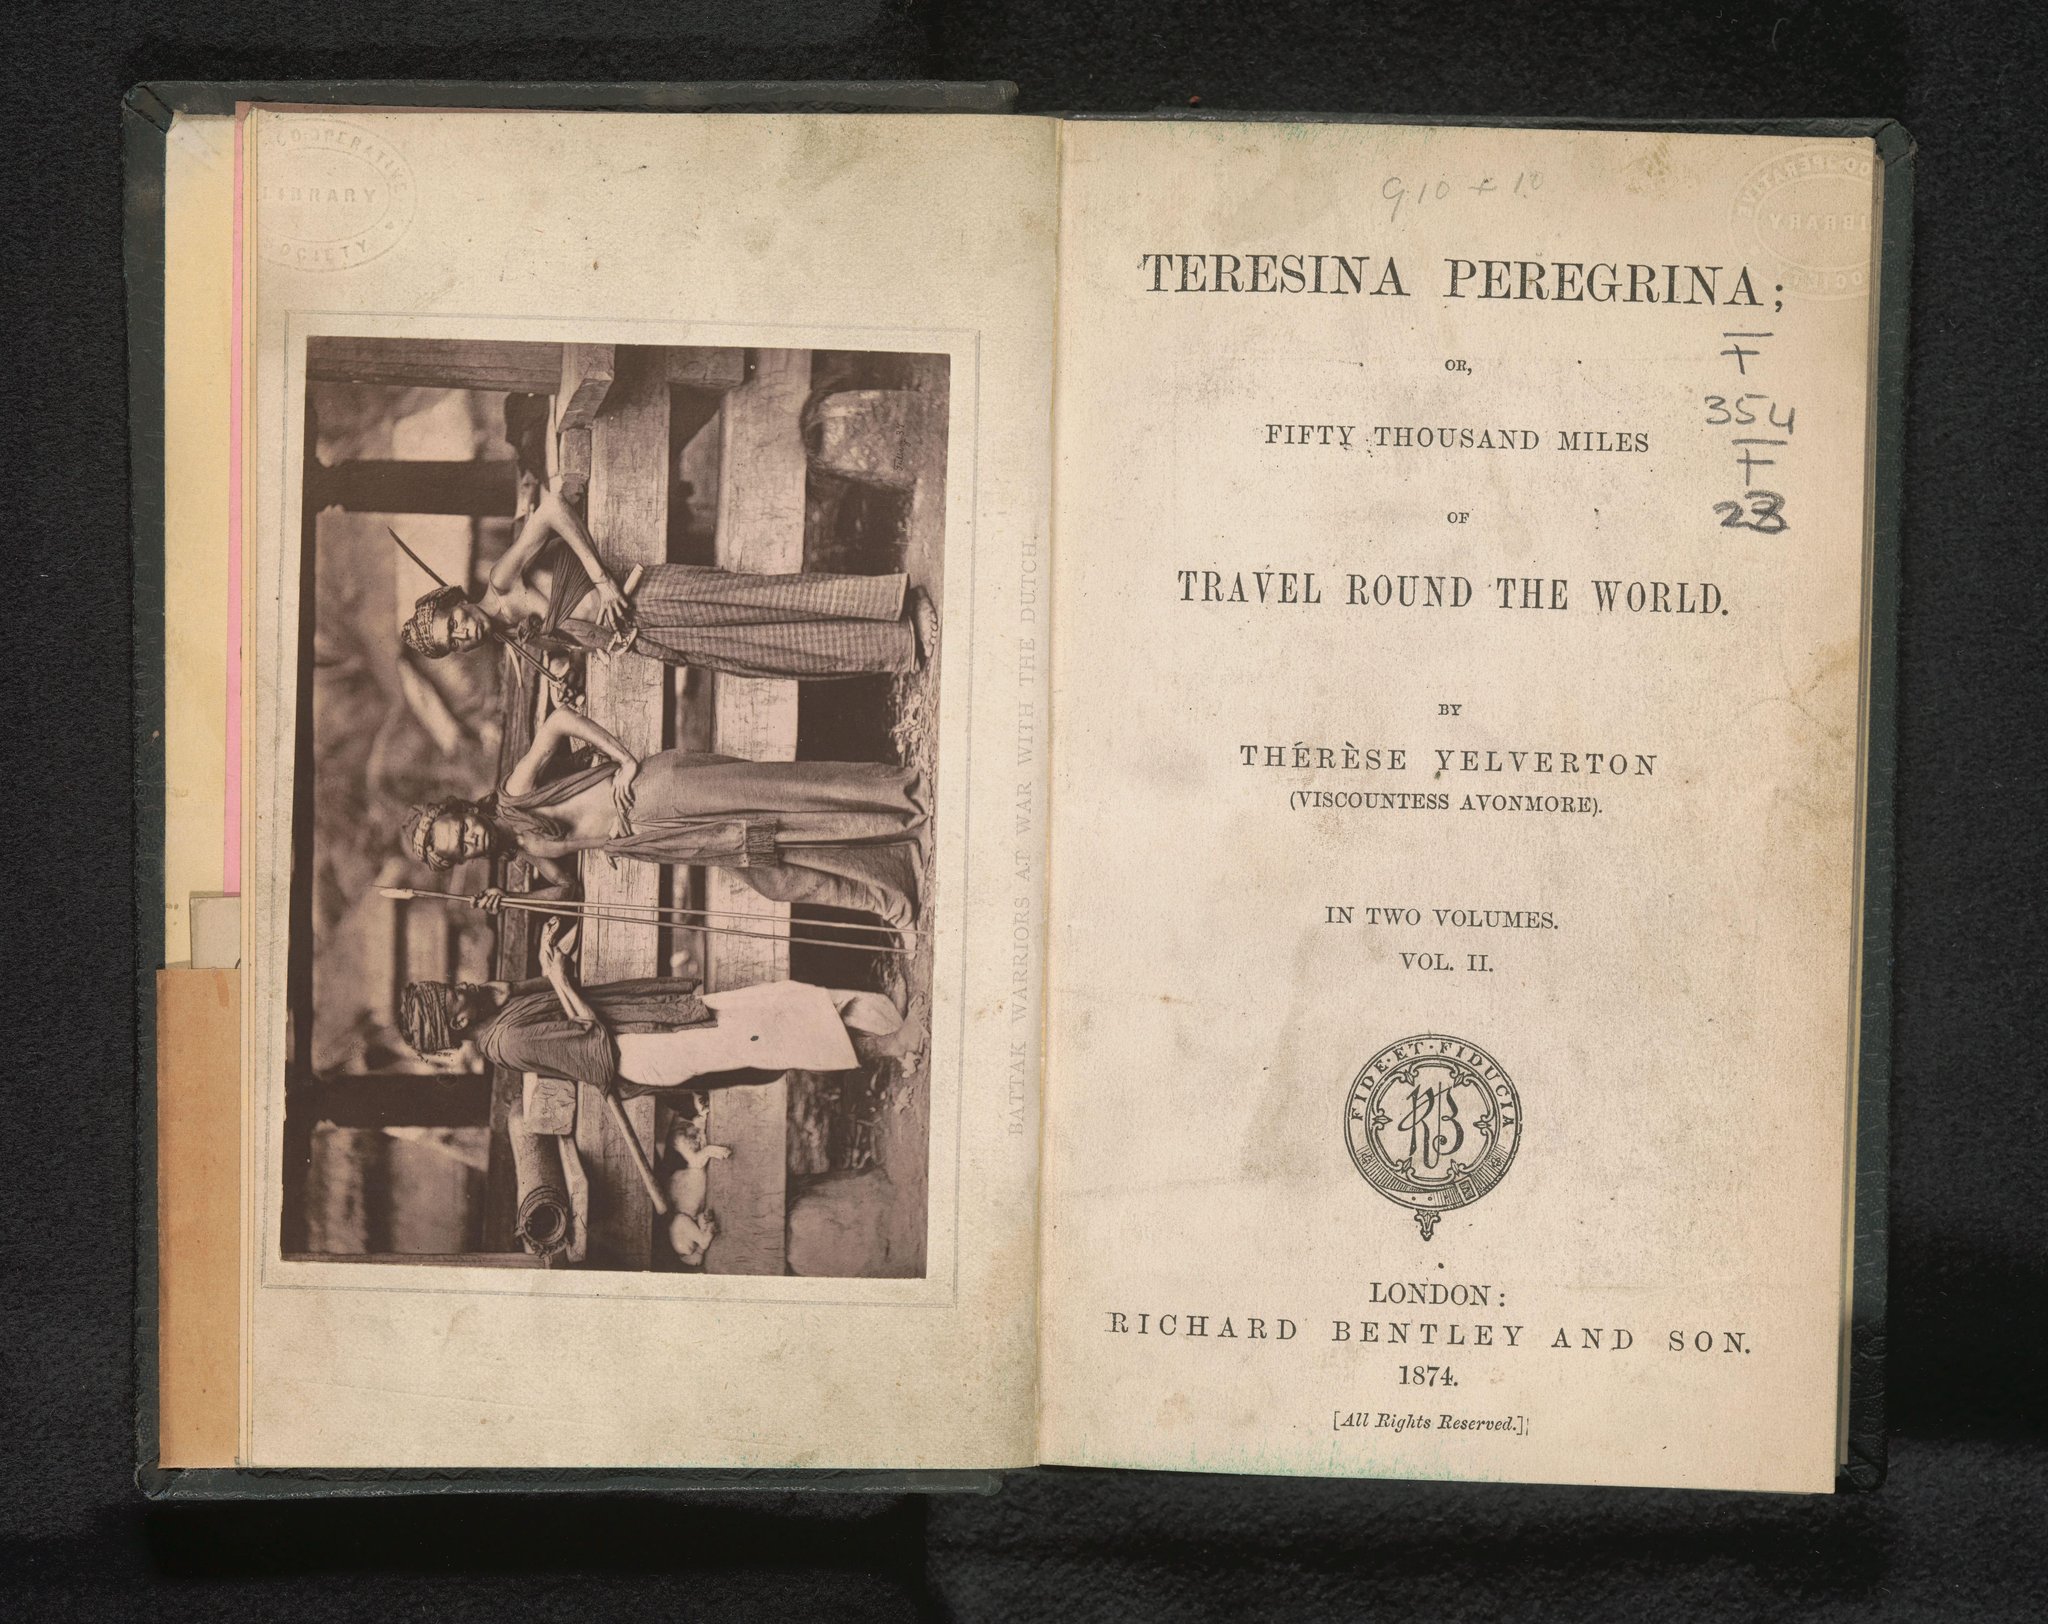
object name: photomechanical print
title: Battak warriors at war with the Dutch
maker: Anonymous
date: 1869-1874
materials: paper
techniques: woodburytype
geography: sumatra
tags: adult man, weapons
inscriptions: inscription: ‘cooperative library society’